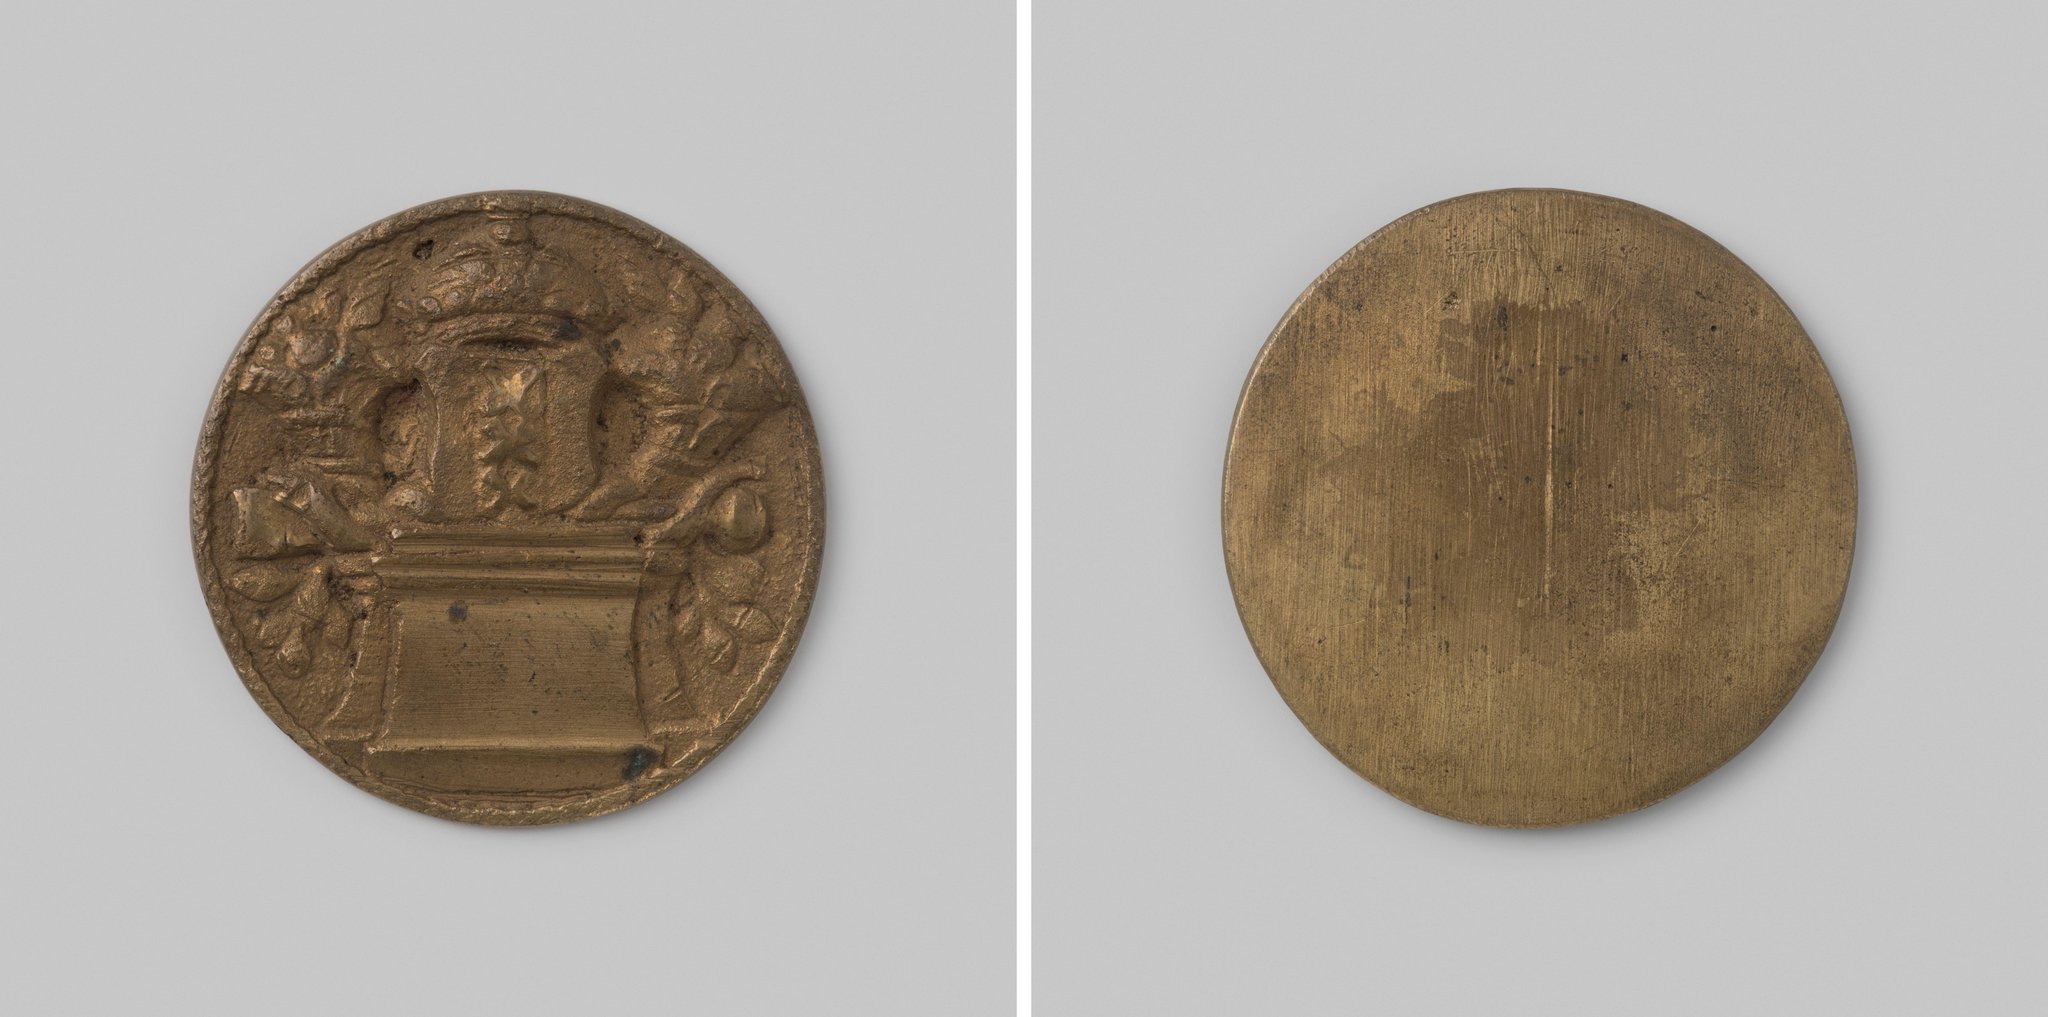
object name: history medal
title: Toegangspenning voor de Hortus Medicus te Amsterdam voor leerlingen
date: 1650-1800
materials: brass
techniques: casting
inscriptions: inscription: ‘sporen van weggeslepen inscriptie’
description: Gegoten messing penning met op de voorzijde een altaar met het gekroonde wapenschild van Amsterdam, een caduceus en cornucopiae waaruit kruidentakken, de keerzijde afgeslepen